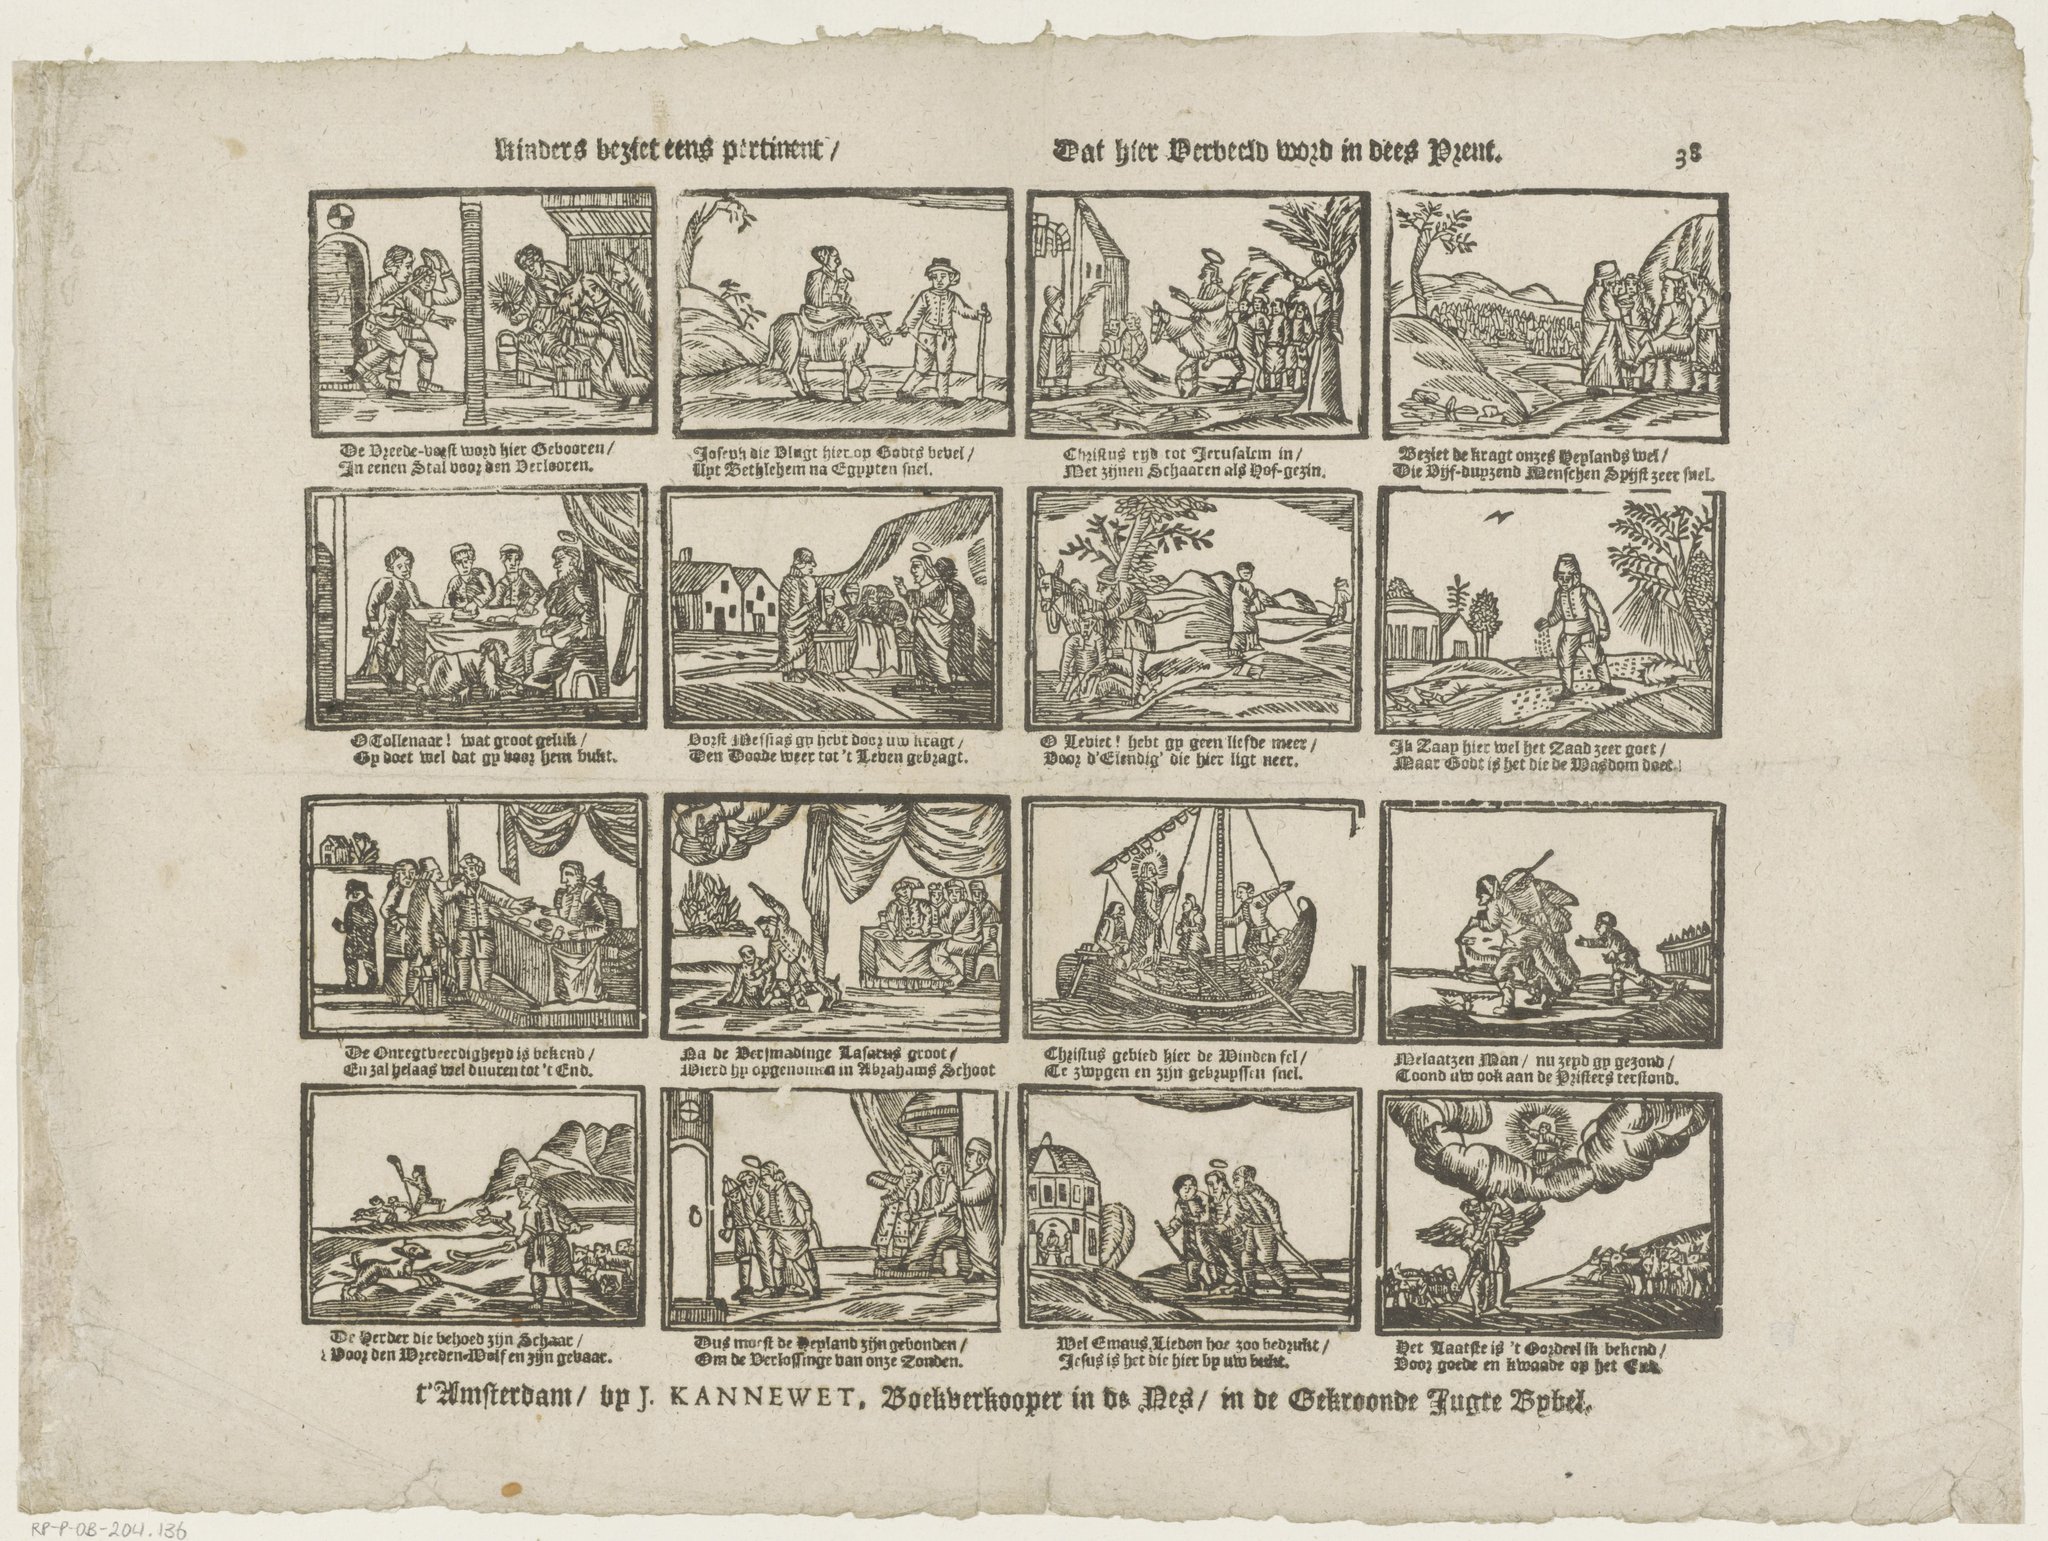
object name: popular print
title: Kinders beziet eens pertinent / Dat hier verbeeld word in dees prent.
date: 1725-1780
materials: paper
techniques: letterpress printing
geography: amsterdam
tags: public life of christ: from his baptism until the passion, birth and youth of christ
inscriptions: collector's mark: Lugt 2760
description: Blad met 16 voorstellingen uit het leven van Christus, zoals de geboorte van Christus en het Laatste Oordeel. Onder elke afbeelding een tweeregelig vers. Genummerd rechtsboven: 38.